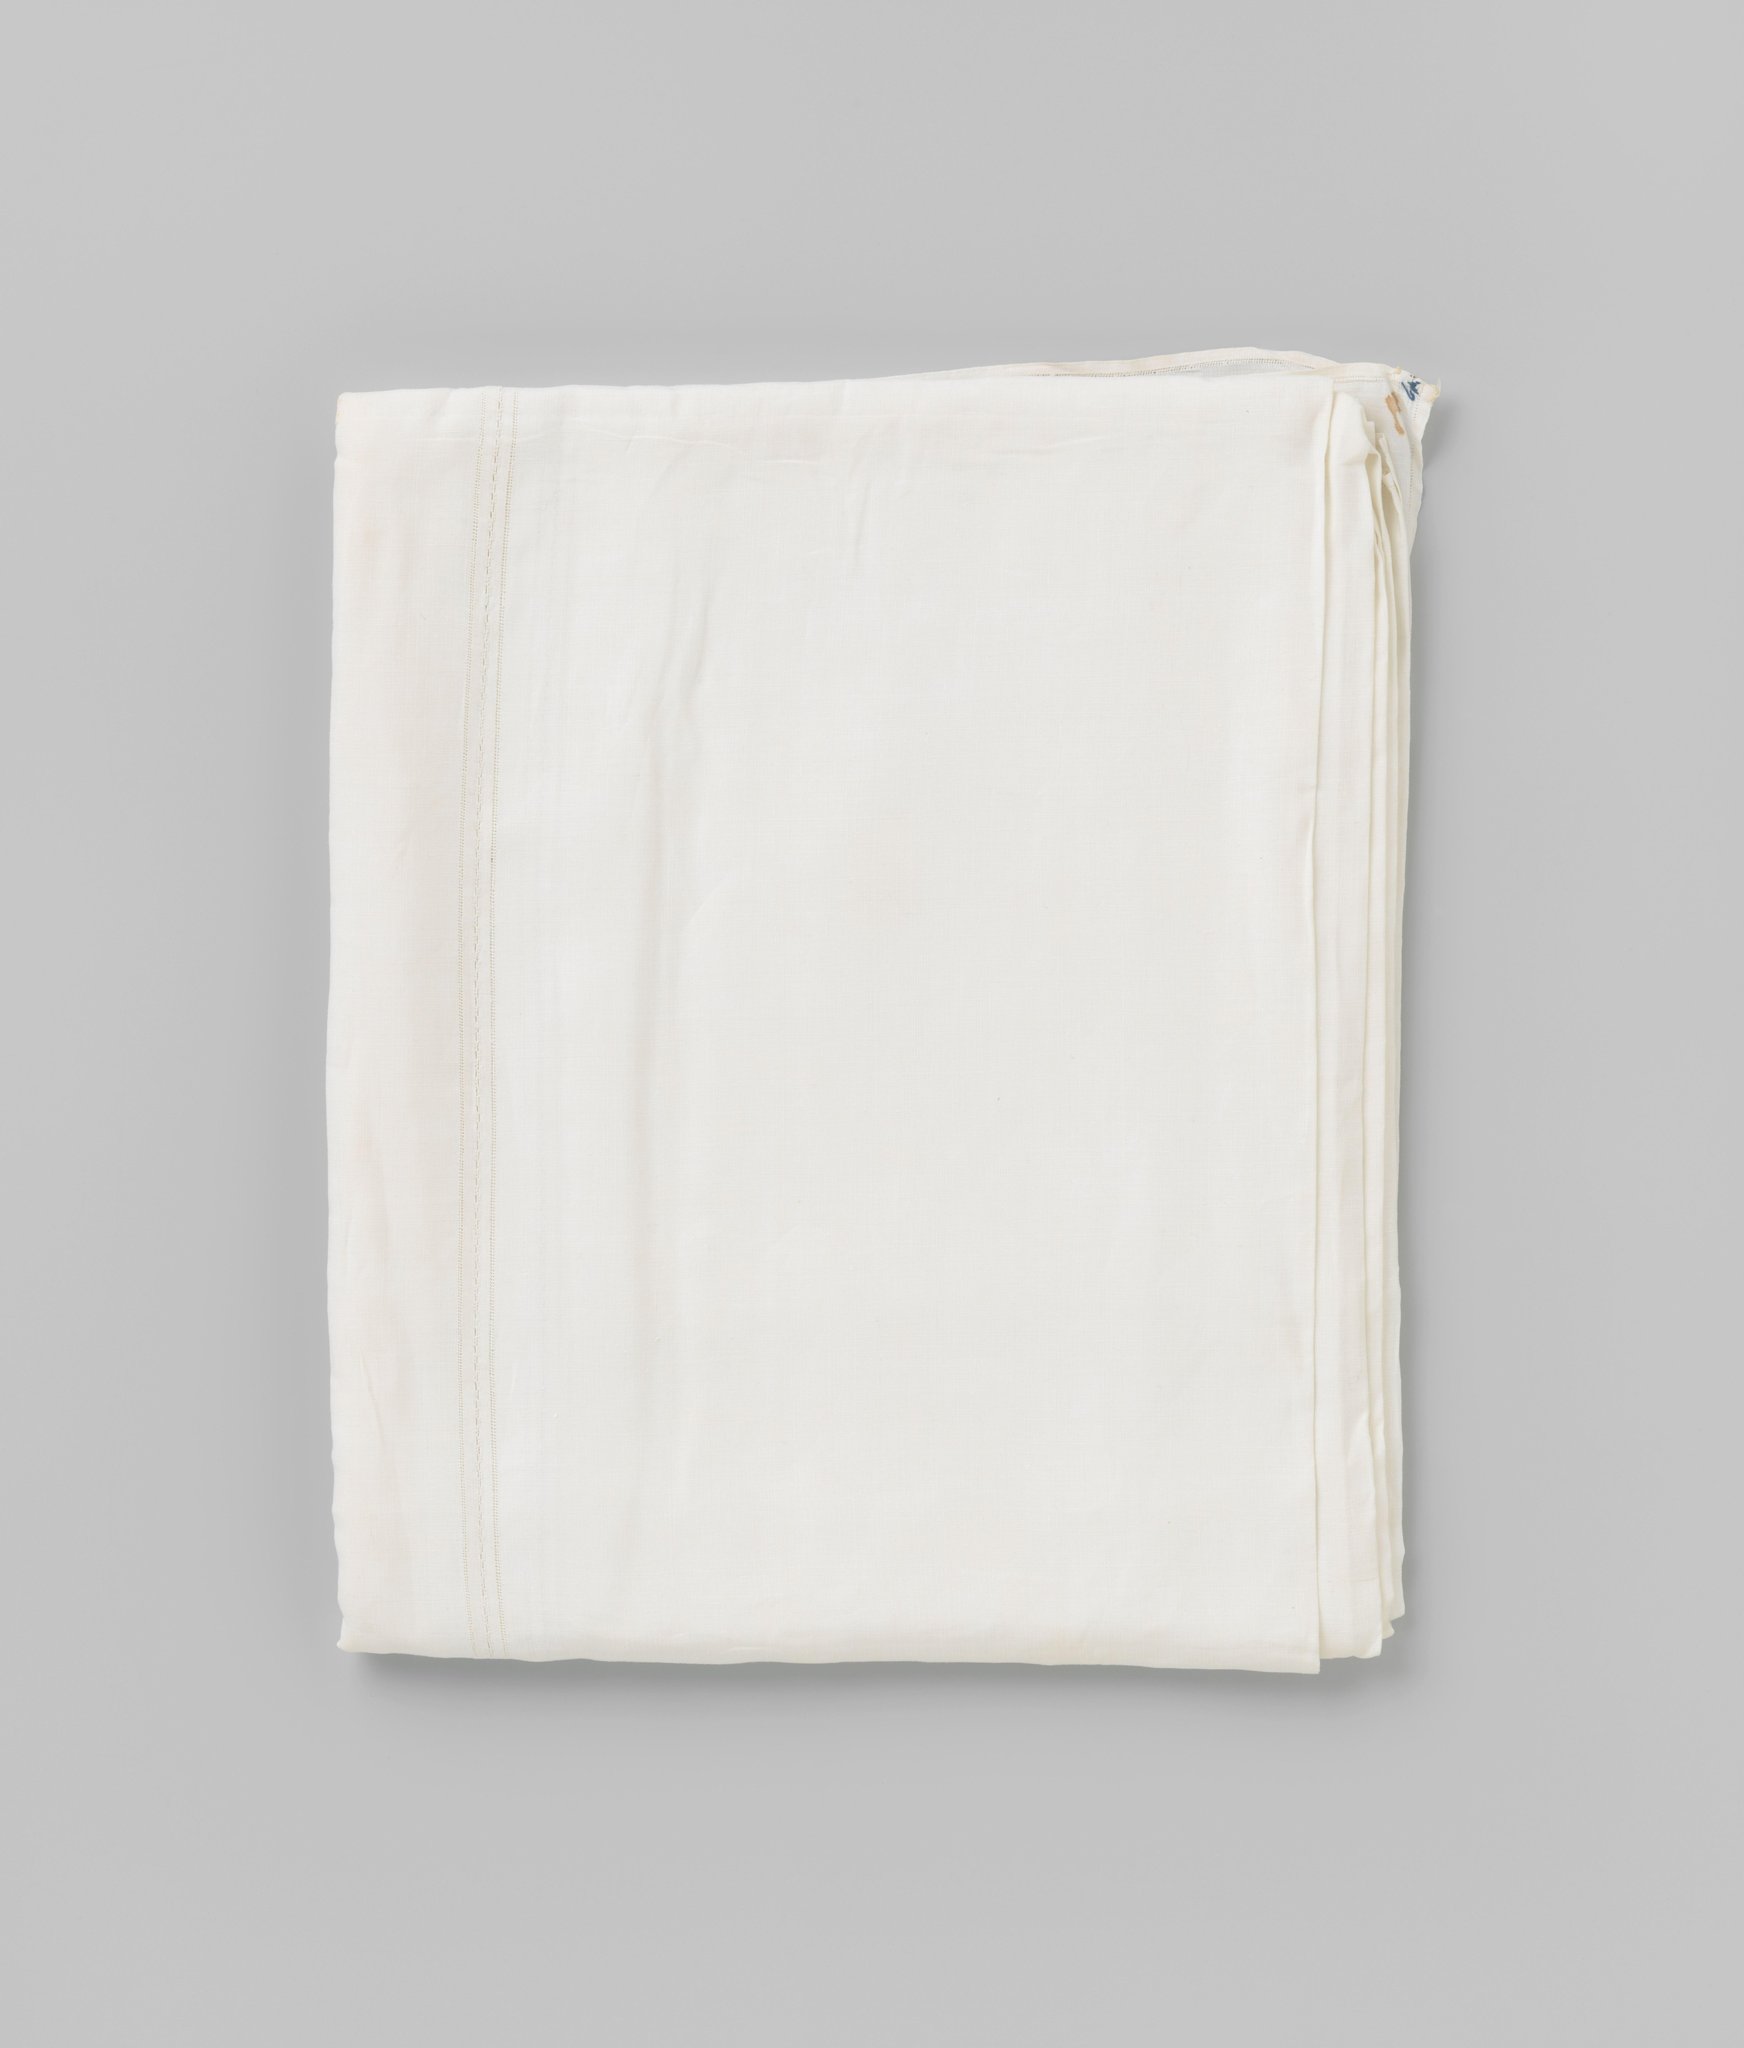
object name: beddenlaken, laken object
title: Laken met open zomen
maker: Anonymous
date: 1700-1900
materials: linen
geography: netherlands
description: Laken van fijn linnen met open zomen, vervaardigd uit tweeëneenhalve baan stof.